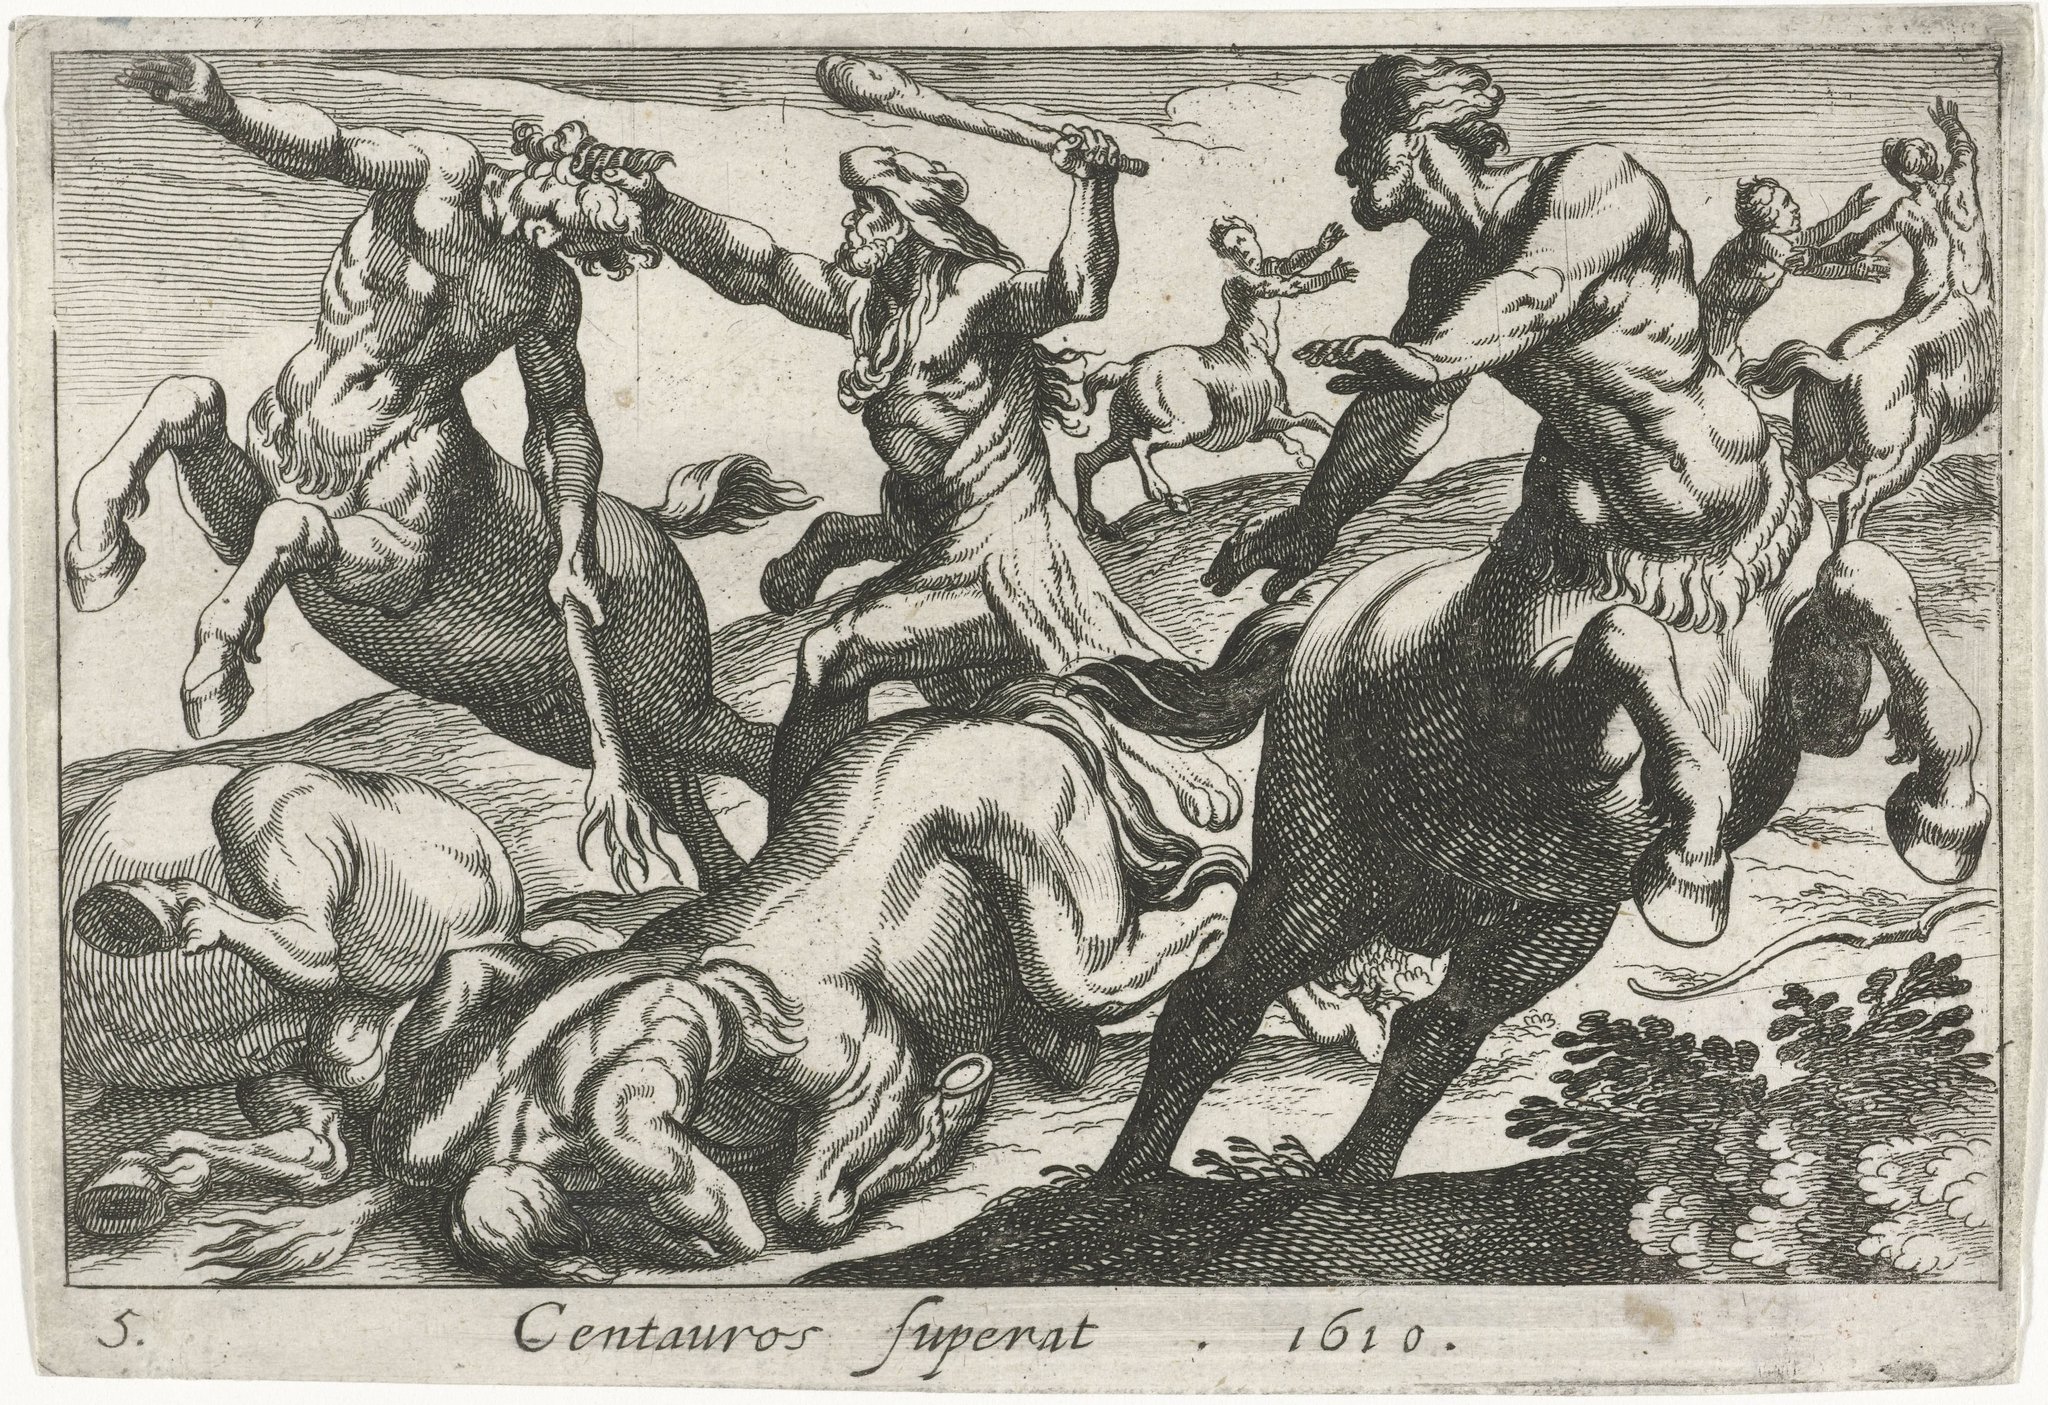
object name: print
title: Centauros superat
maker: simon frisius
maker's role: print maker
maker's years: 1570-1628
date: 1610-1664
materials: paper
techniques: etching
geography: italy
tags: hercules' fight with the centaurs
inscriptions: collector's mark: Lugt 240